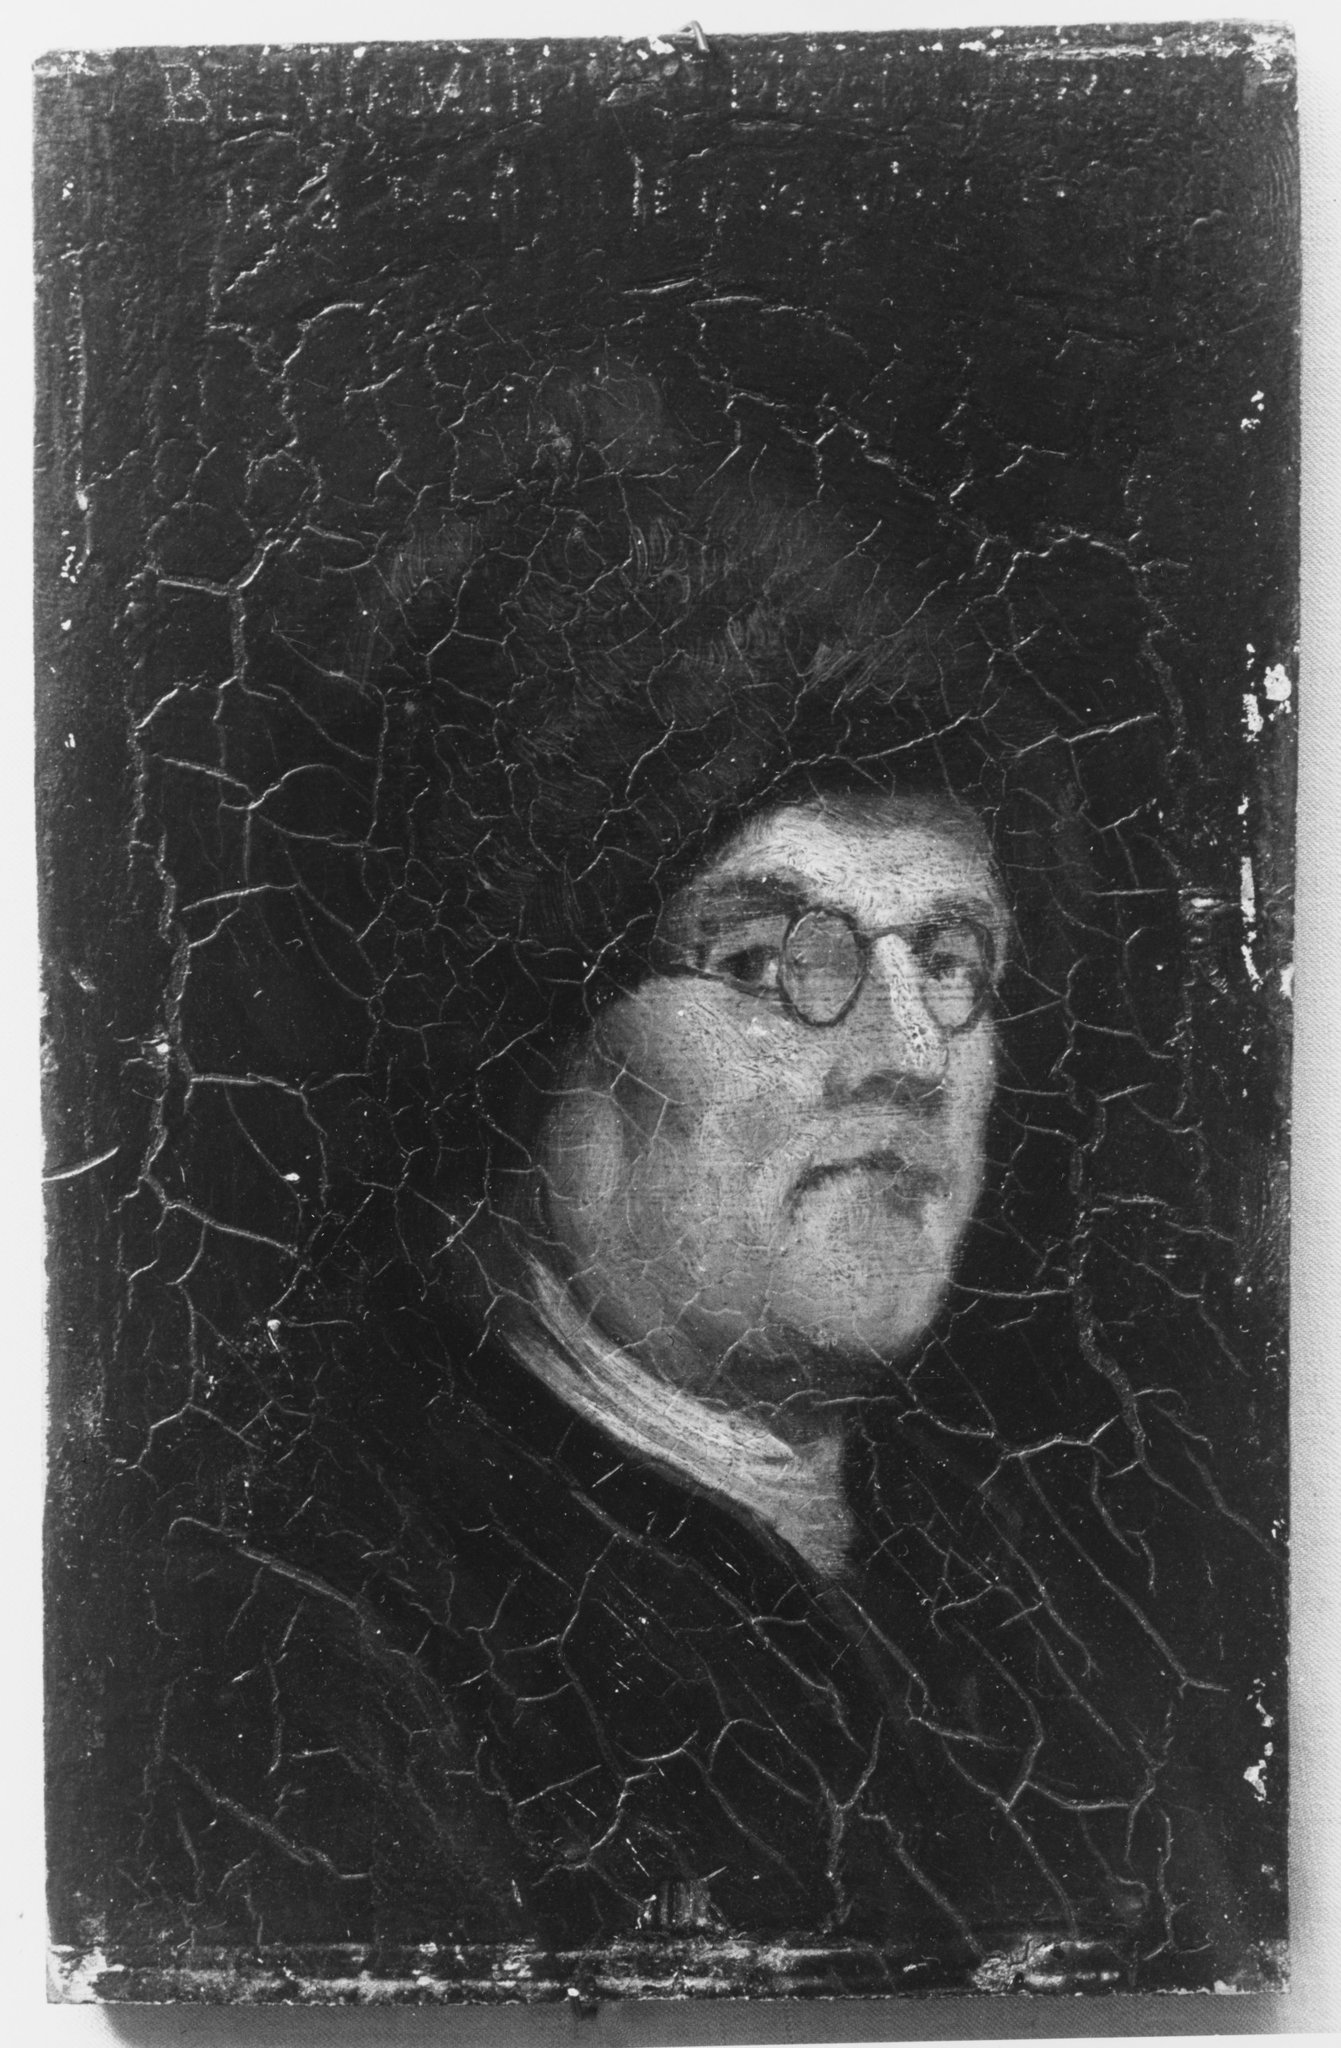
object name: painting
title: Portrait of Benjamin Franklin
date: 1776-1883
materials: oil, wood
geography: france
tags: benjamin franklin,men,portraits